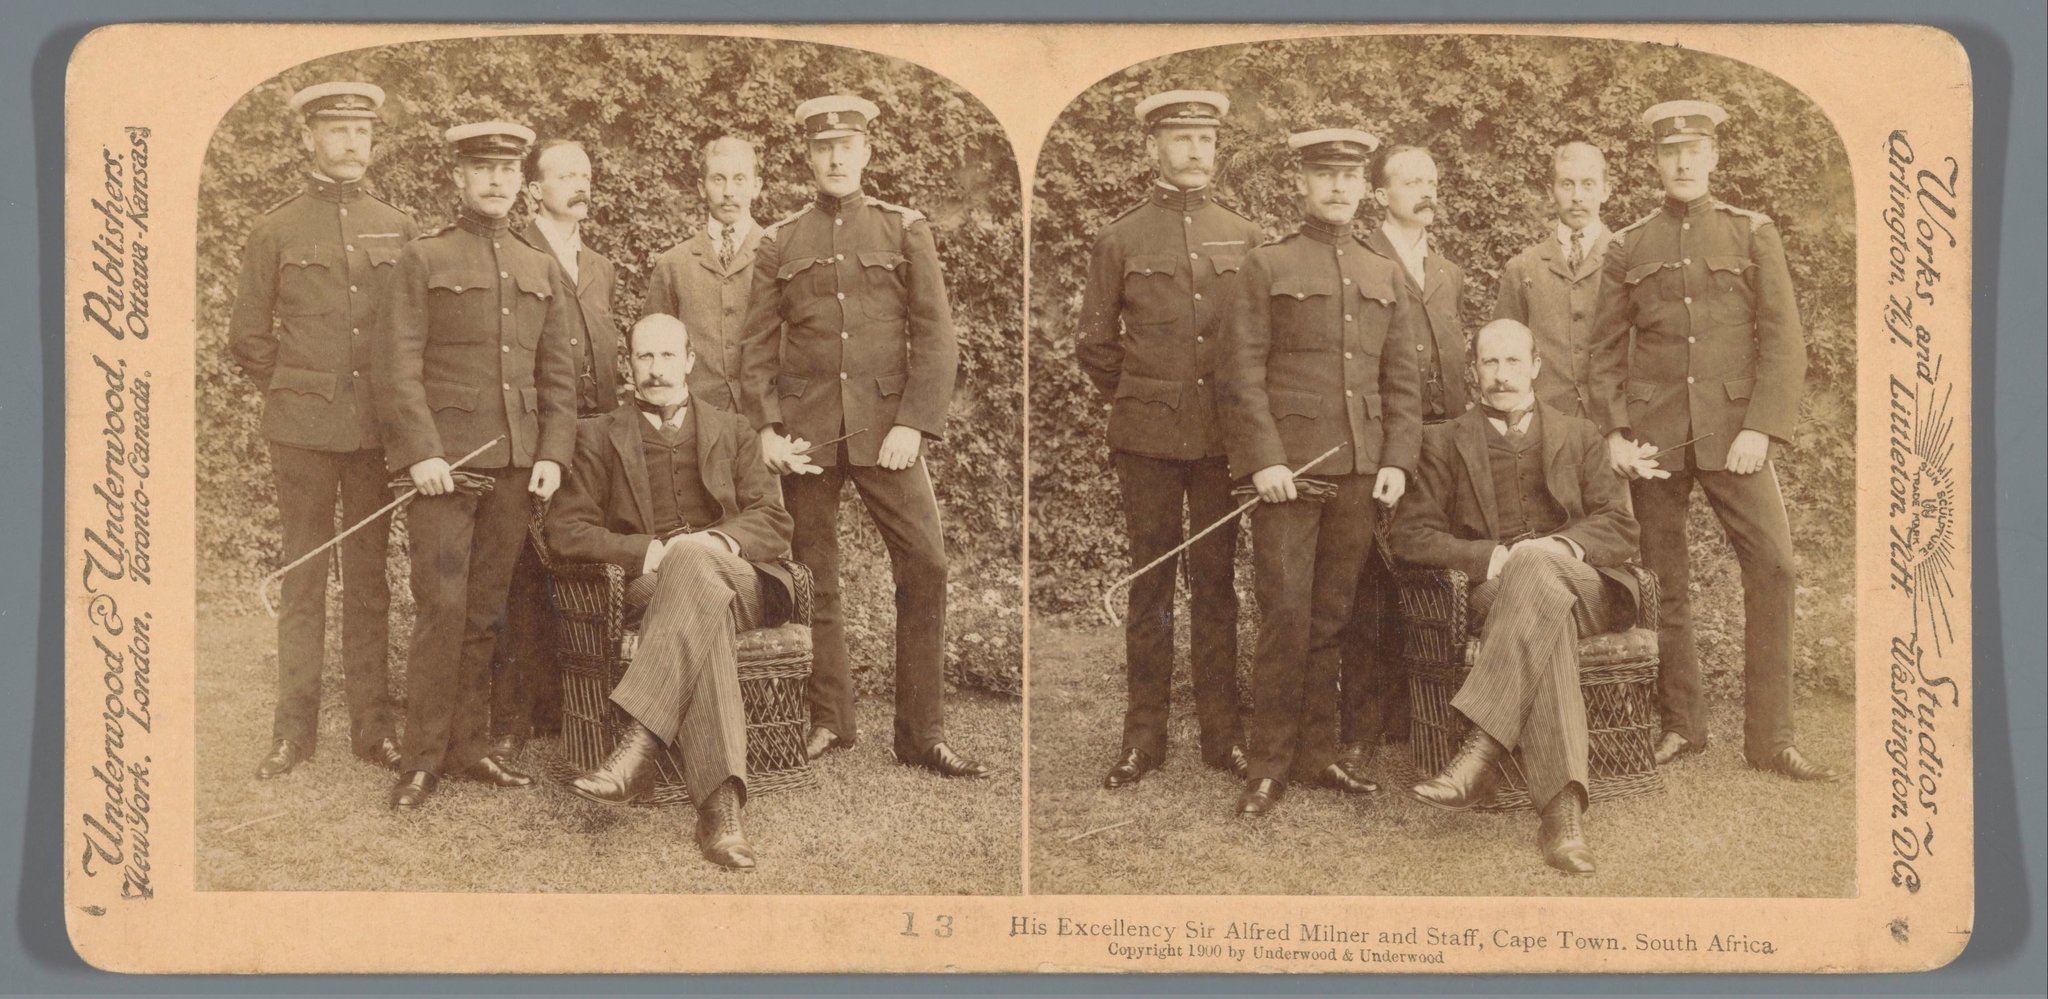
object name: stereograph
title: His Excellency Sir Alfred Milner and Staff, Cape Town, South Africa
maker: Anonymous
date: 1900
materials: cardboard, paper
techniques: albumen print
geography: new york city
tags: politician, politician, e.g. party leader, anonymous historical persons portrayed in a group, in a group-portrait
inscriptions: inscription, inscription: ‘Works and Studios ~/ Arlington, N.J. Littleton, N.H. Washington, D.C.’, copyright notice: ‘Copyright 1900 by Underwood & Underwood.’, number: ‘13’